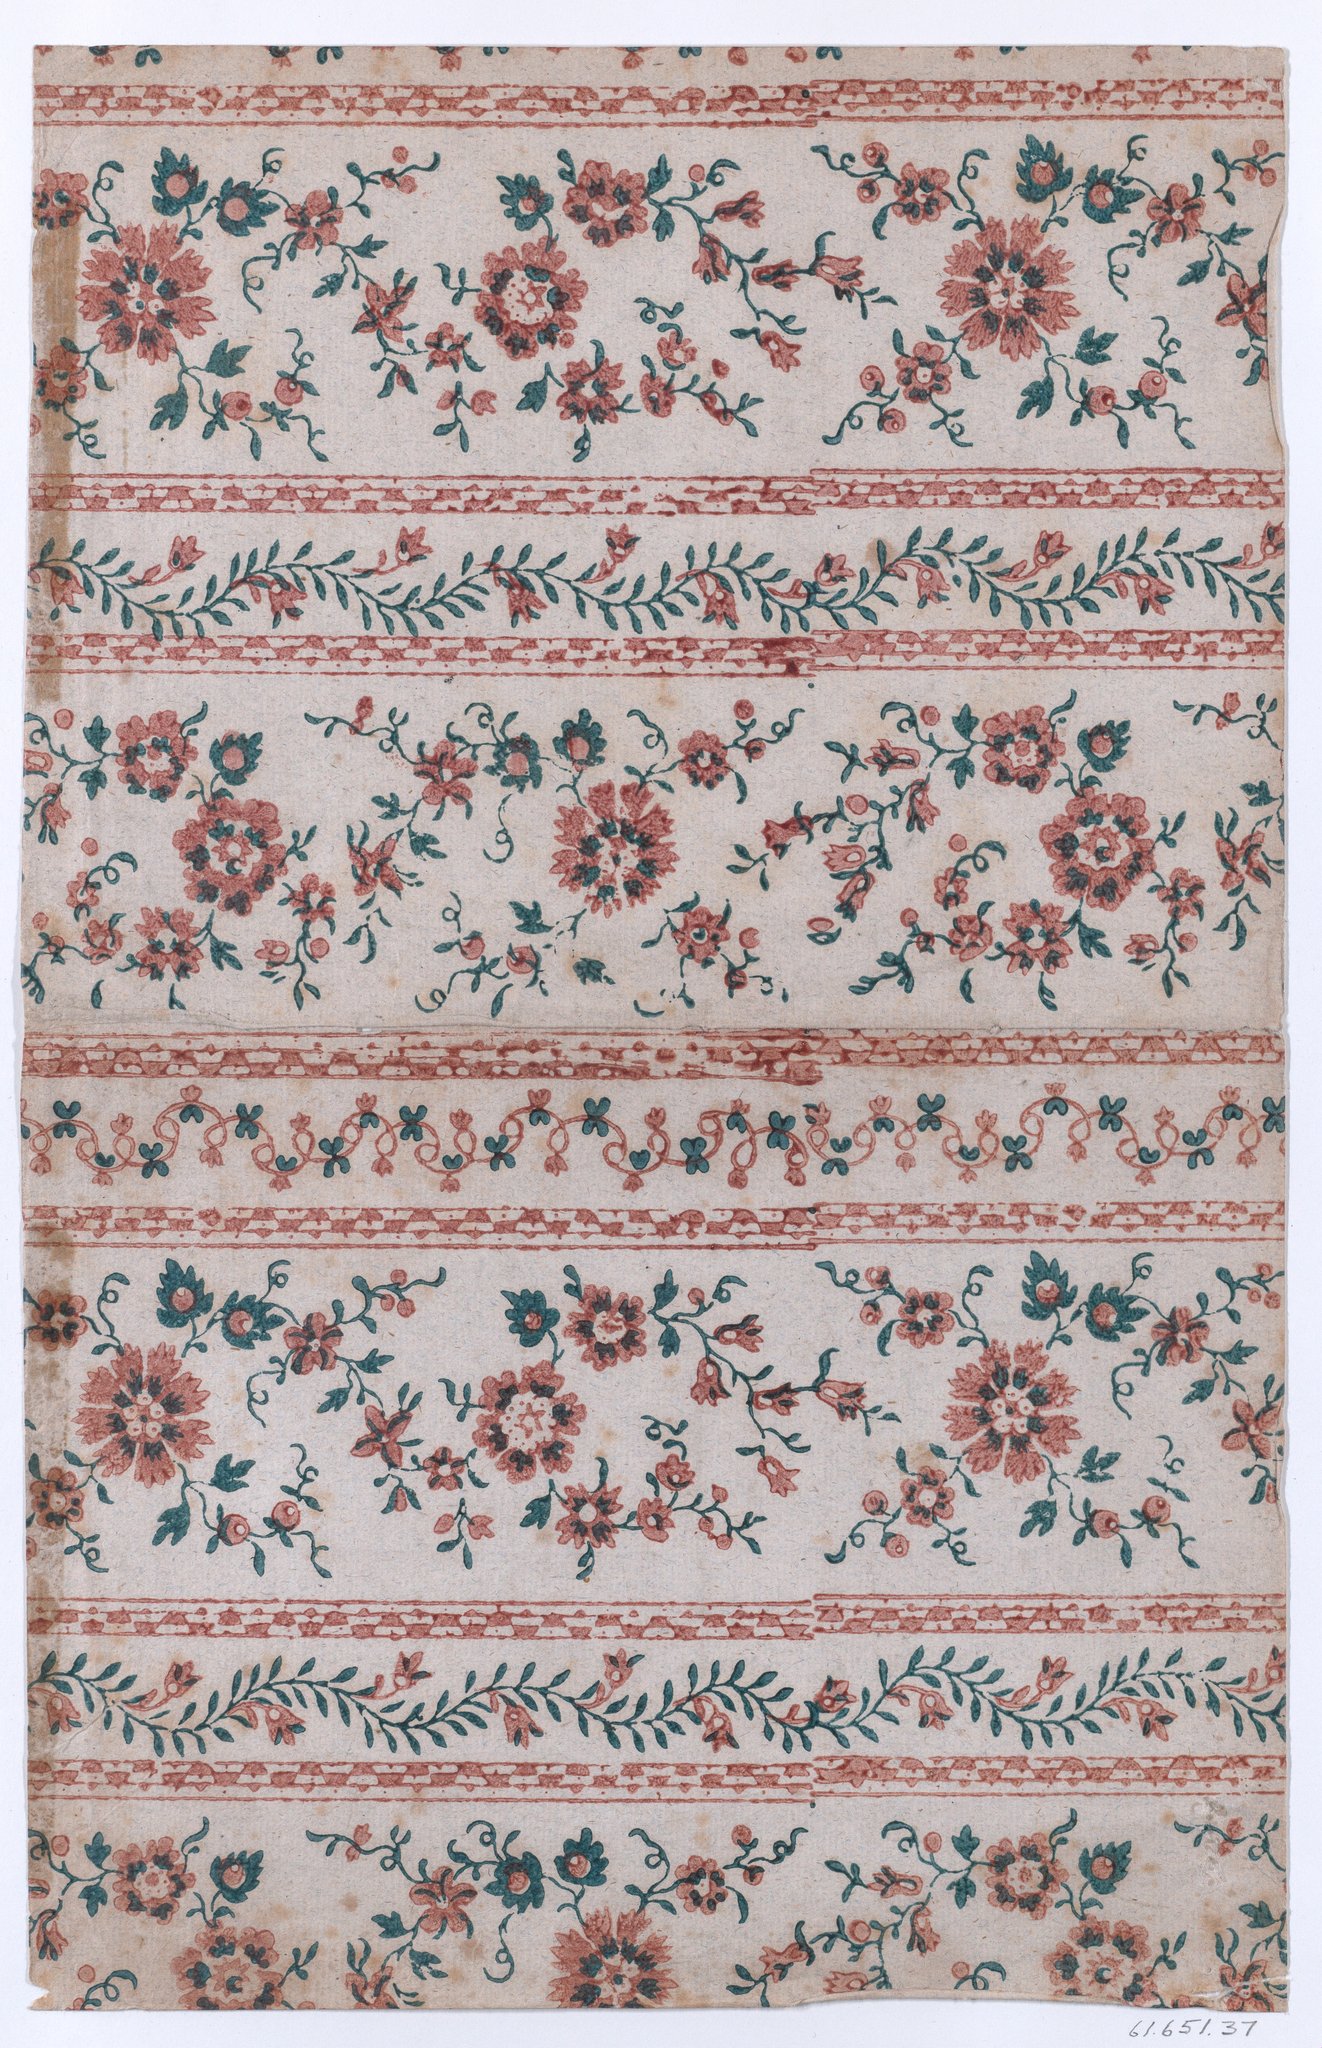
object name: print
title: Book cover with two borders with floral patterns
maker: Anonymous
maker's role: artist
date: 1801-1900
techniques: relief print